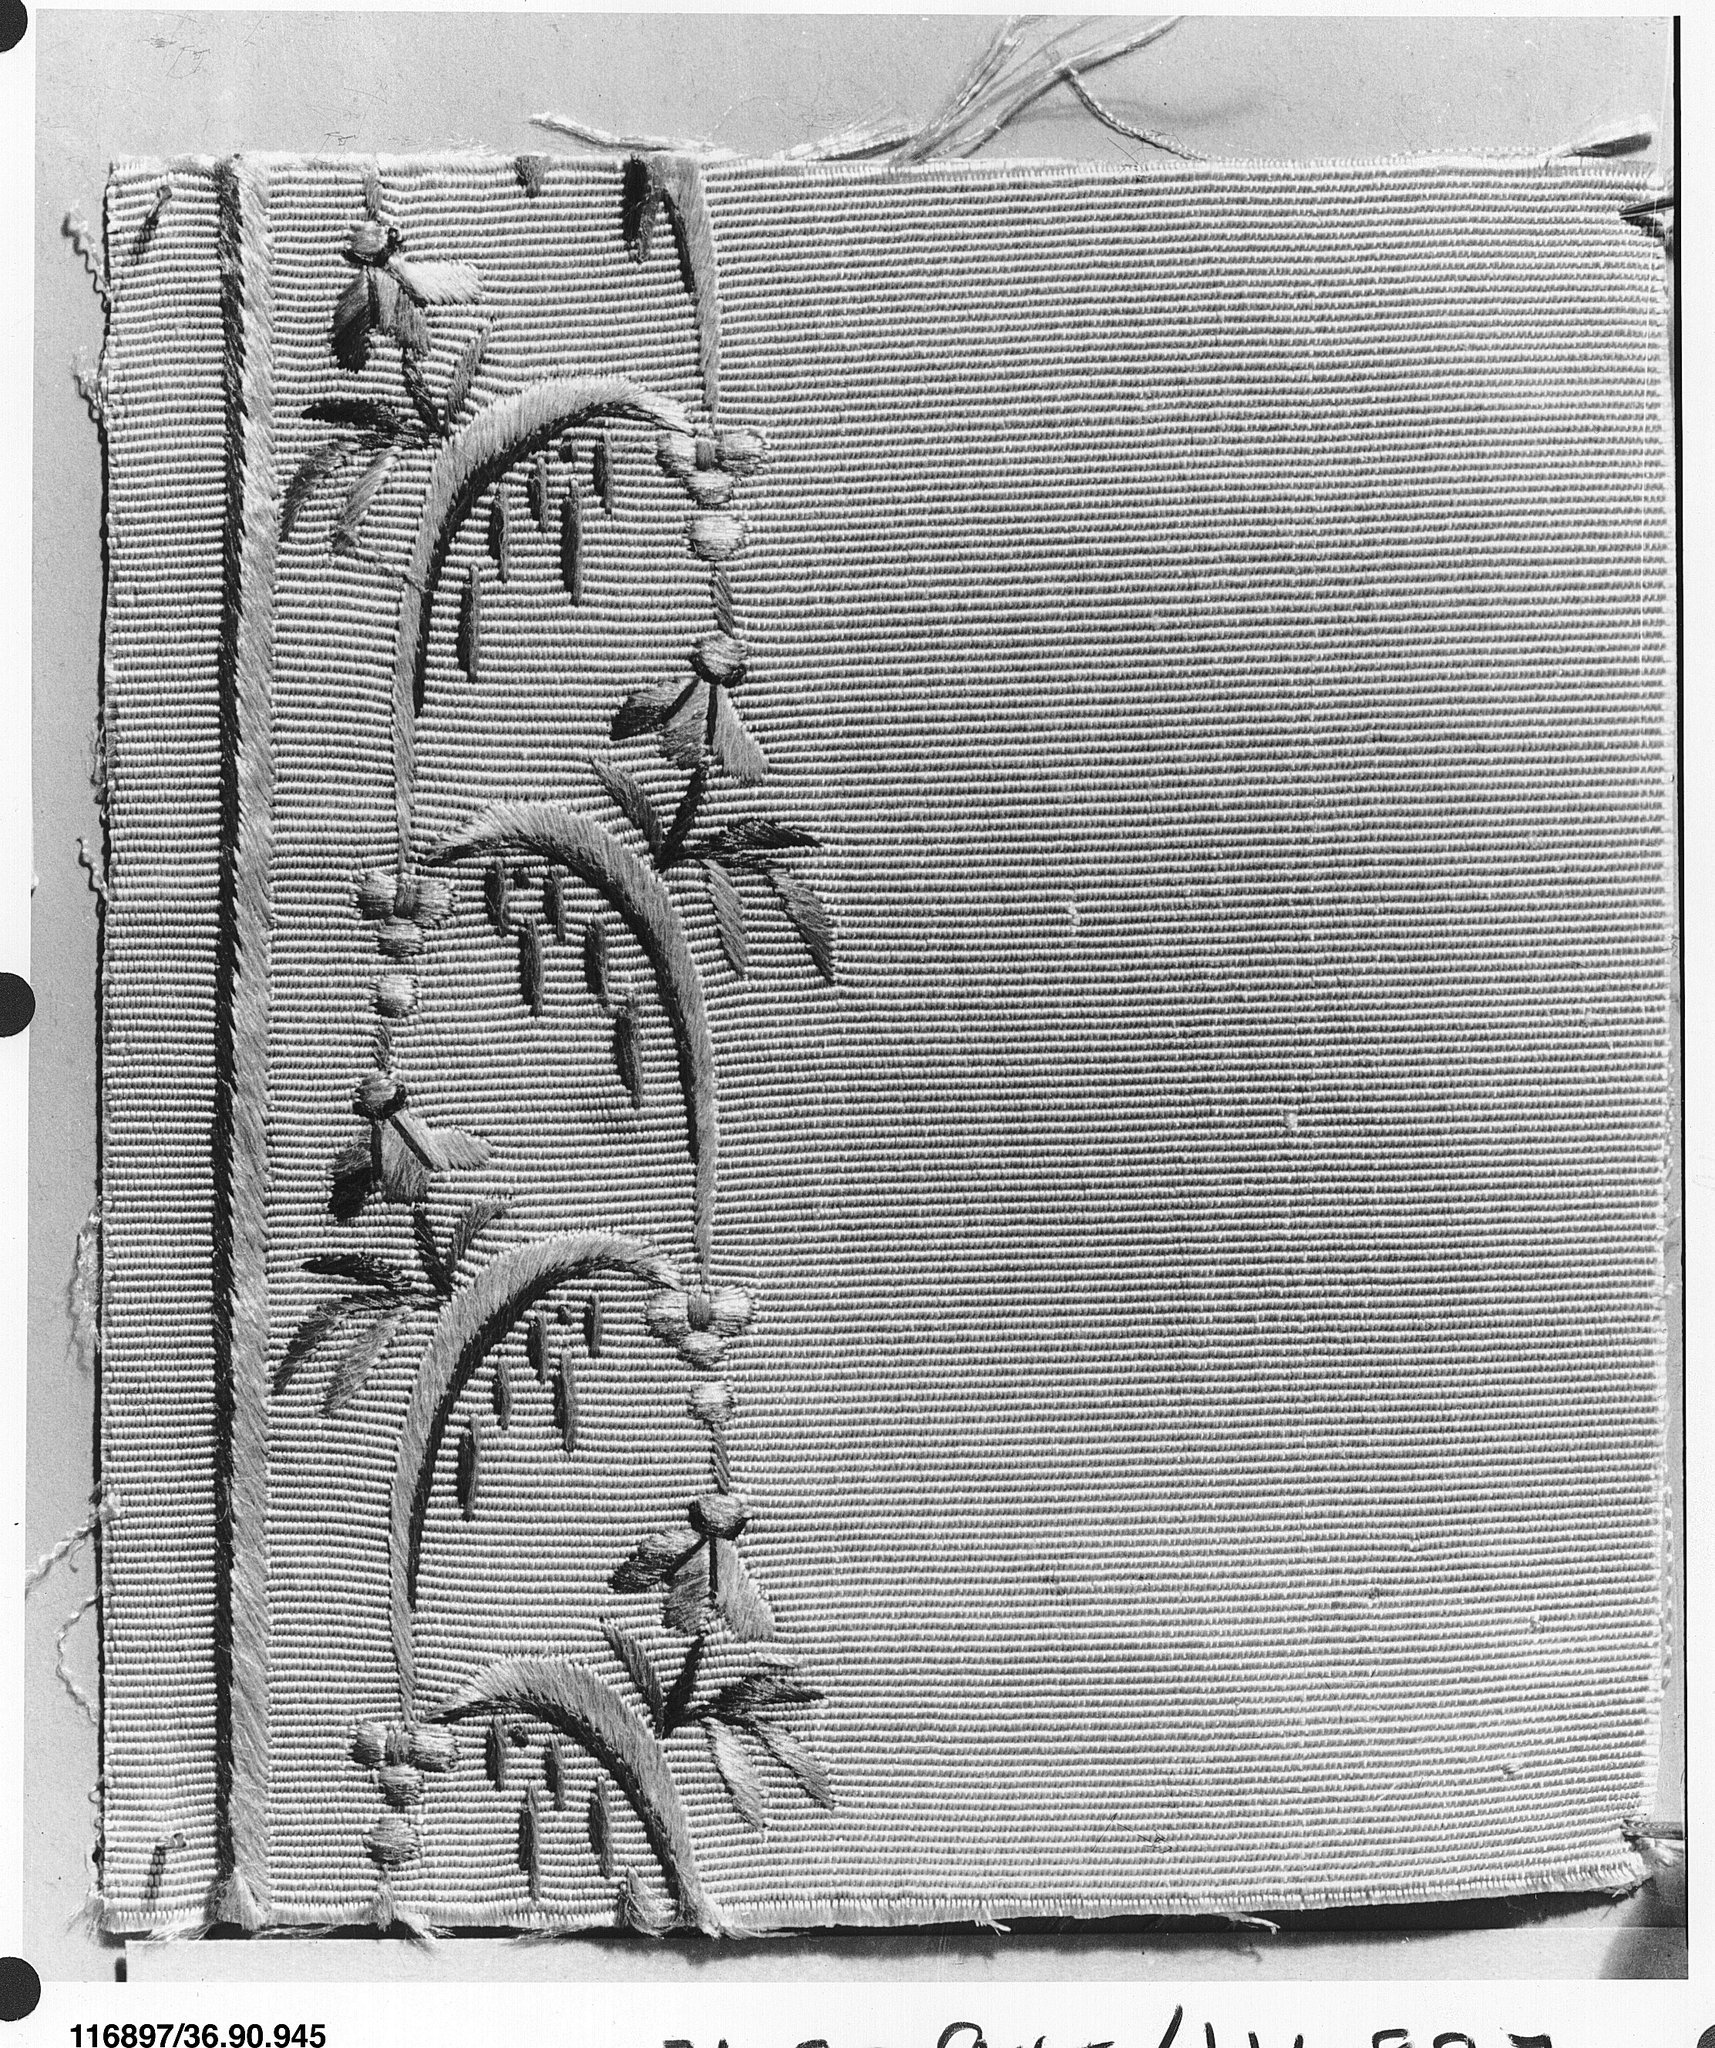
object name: sample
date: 1801-1833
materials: silk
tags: flowers